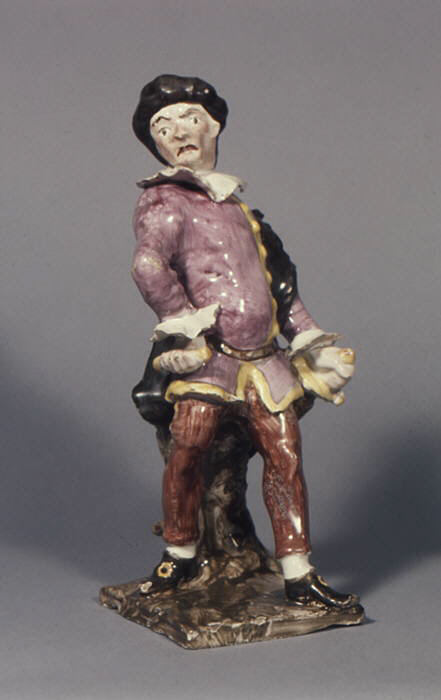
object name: figure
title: The Captain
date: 1740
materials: faience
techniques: glazing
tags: men